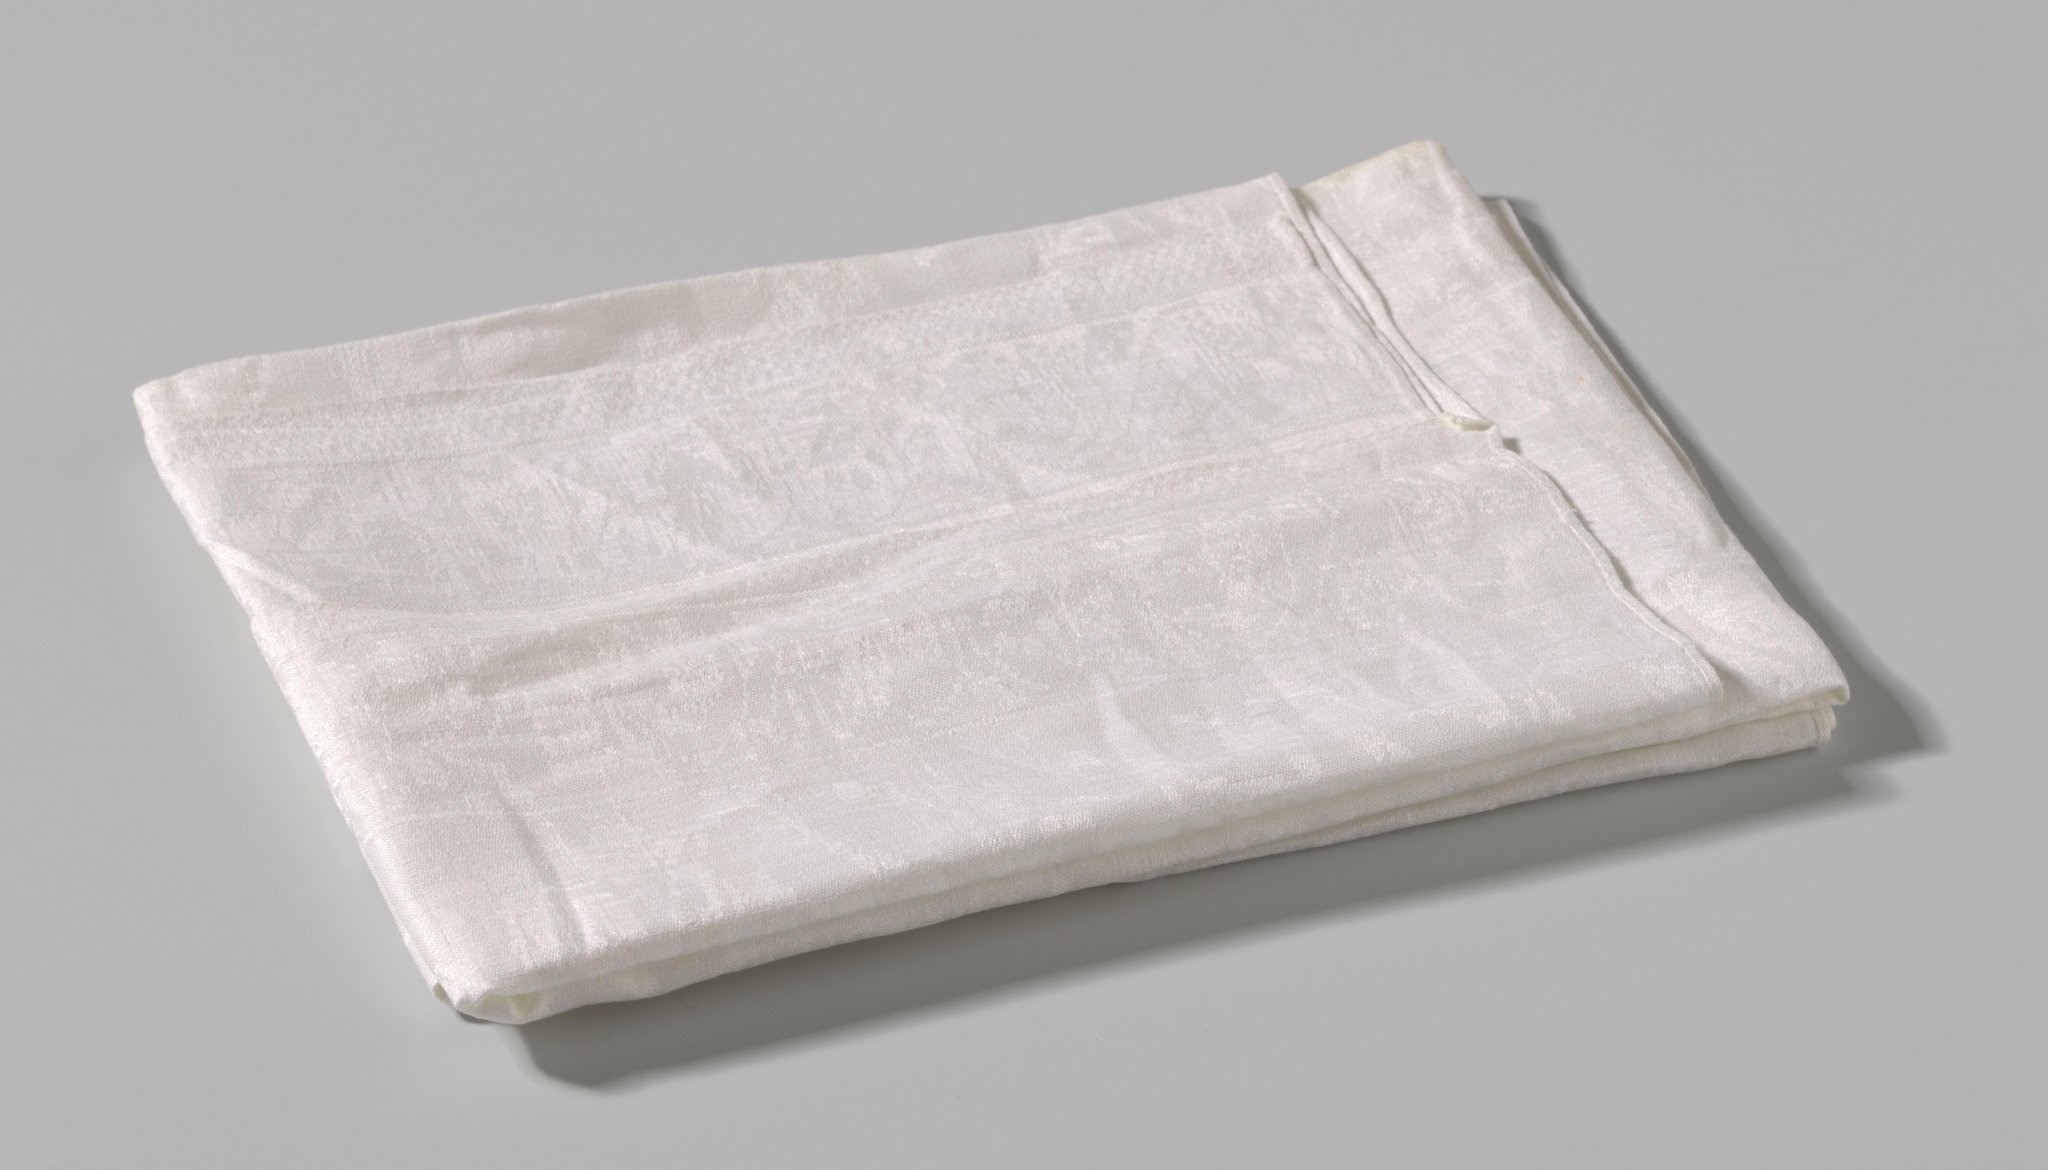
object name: napkin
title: Servet van linnendamast met putti en bloemen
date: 1660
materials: linen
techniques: damask, weave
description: Servet van linnendamast. Het patroon heeft bloemen en vruchten waartussen putti die hoorns des overvloed dragen en putti die een bloemenmand dragen. De lopende rand heeft een golvende lijn waartussen vogels en bloemen en een blokrand. Het servet is stukgoed, waardoor het geen liggende randen en hoeken heeft. Het servet hoort bij een tafellaken (BK-KOG-2607-A).